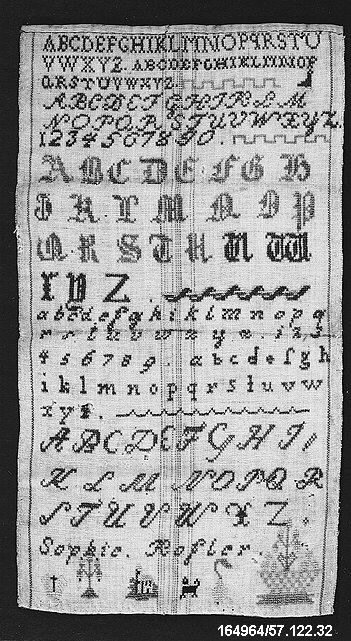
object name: sampler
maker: sophie kofler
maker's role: maker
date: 1801-1900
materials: canvas, silk, wool